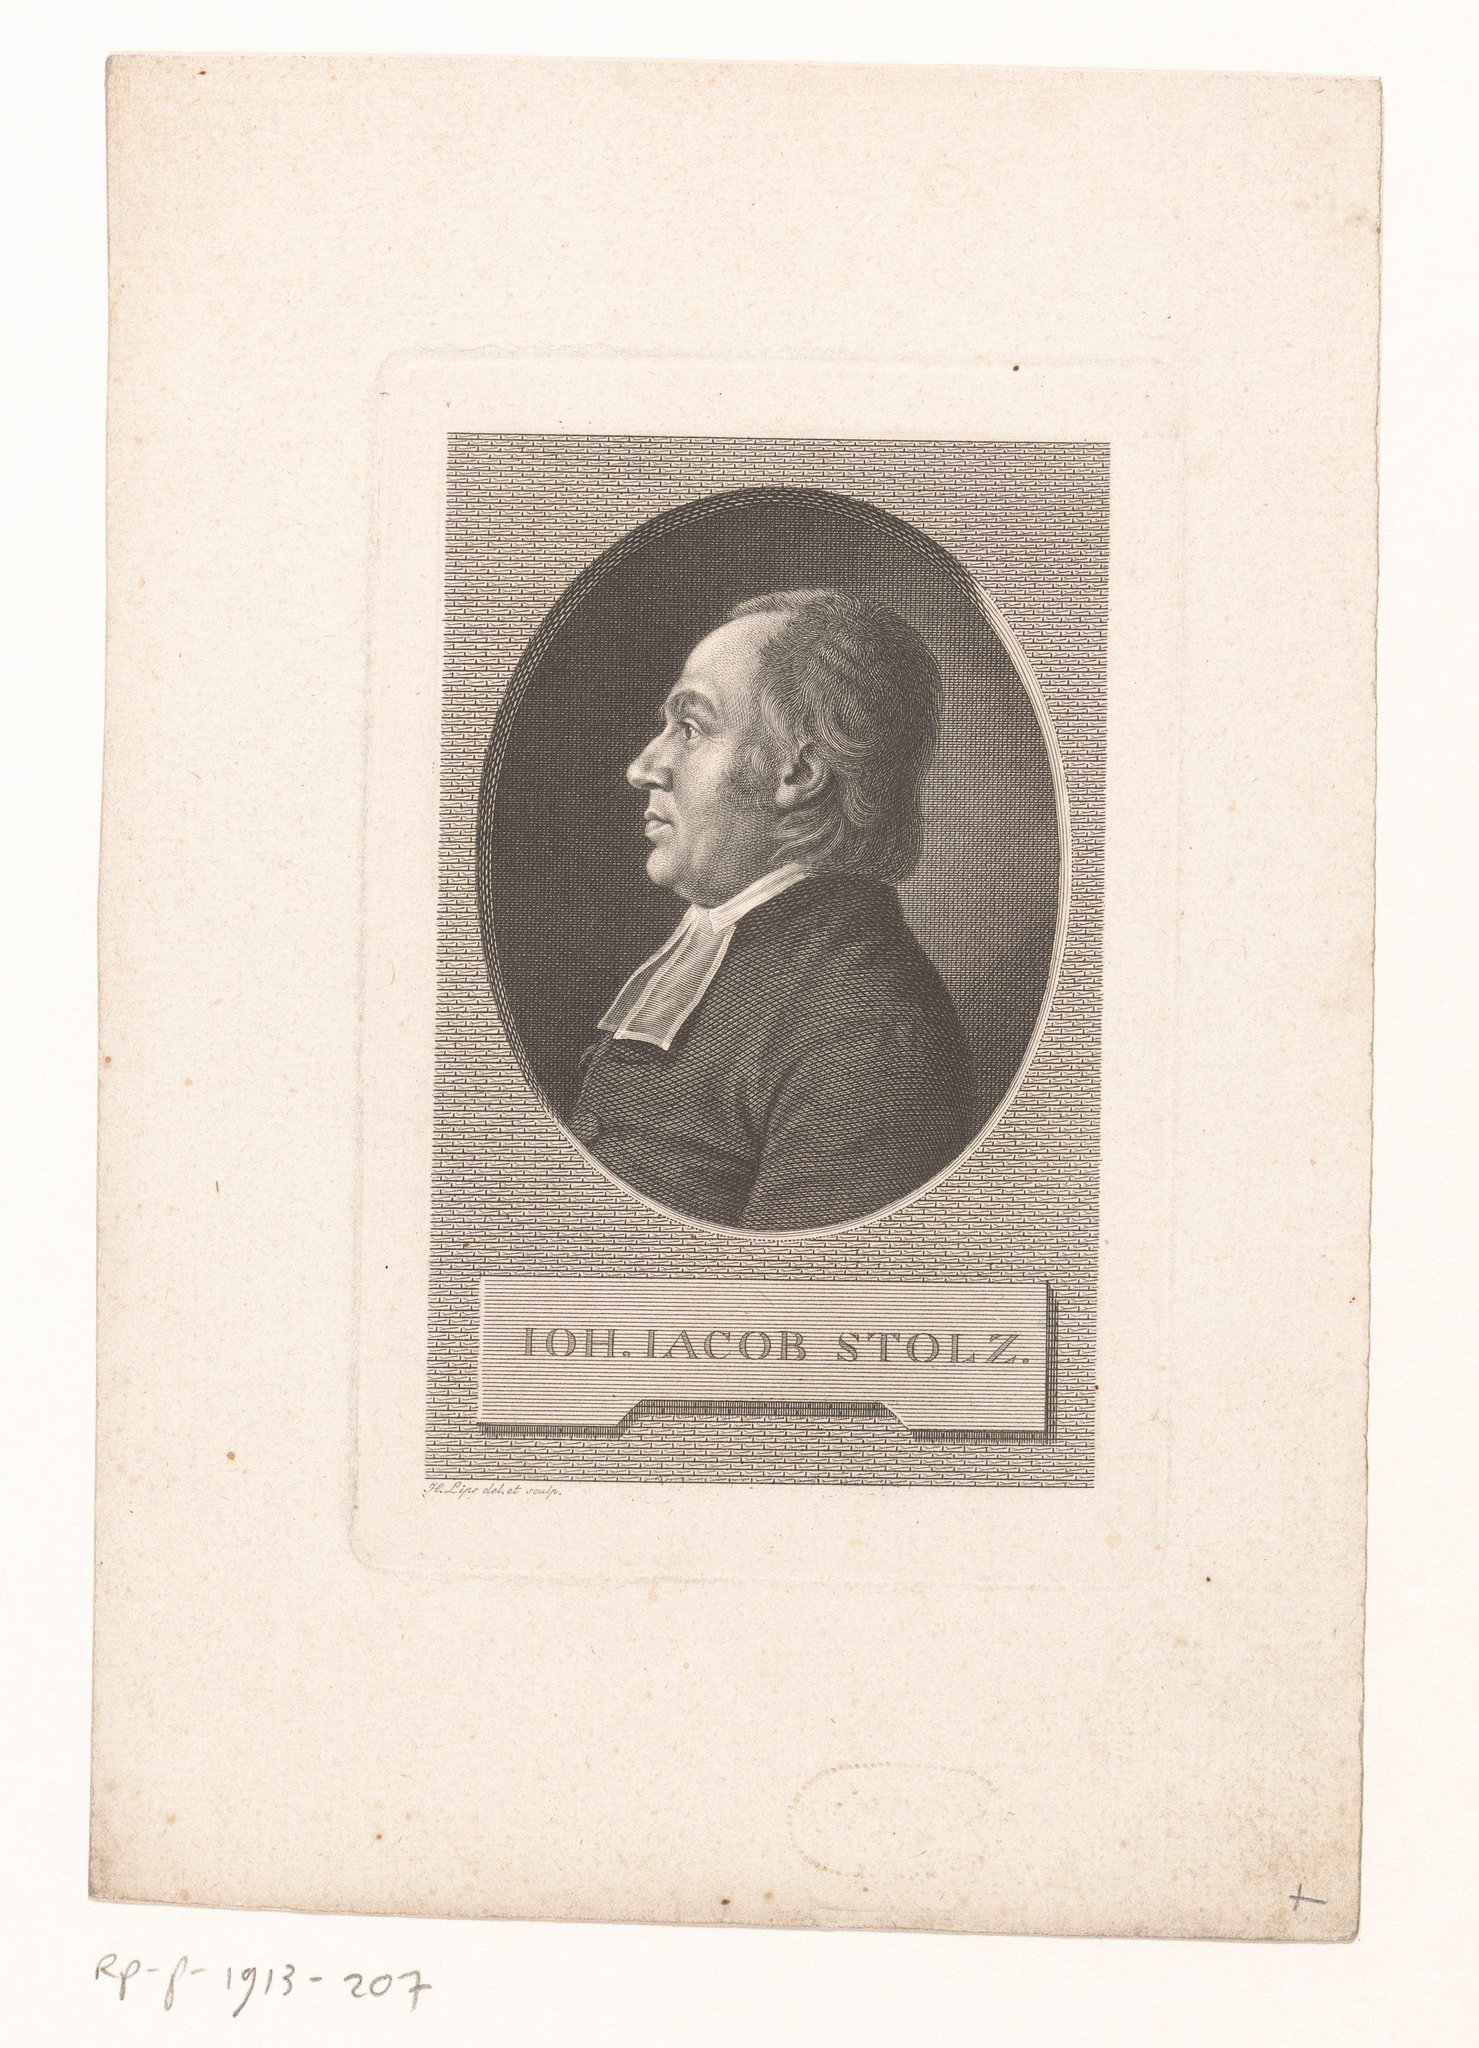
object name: print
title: Portret van Johann Jacob Stolz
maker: johann heinrich lips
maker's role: draughtsman, painter, print maker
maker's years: 1758-1817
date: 1768-1817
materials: paper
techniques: engraving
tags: theologian, historical persons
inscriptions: collector's mark: Lugt 2228